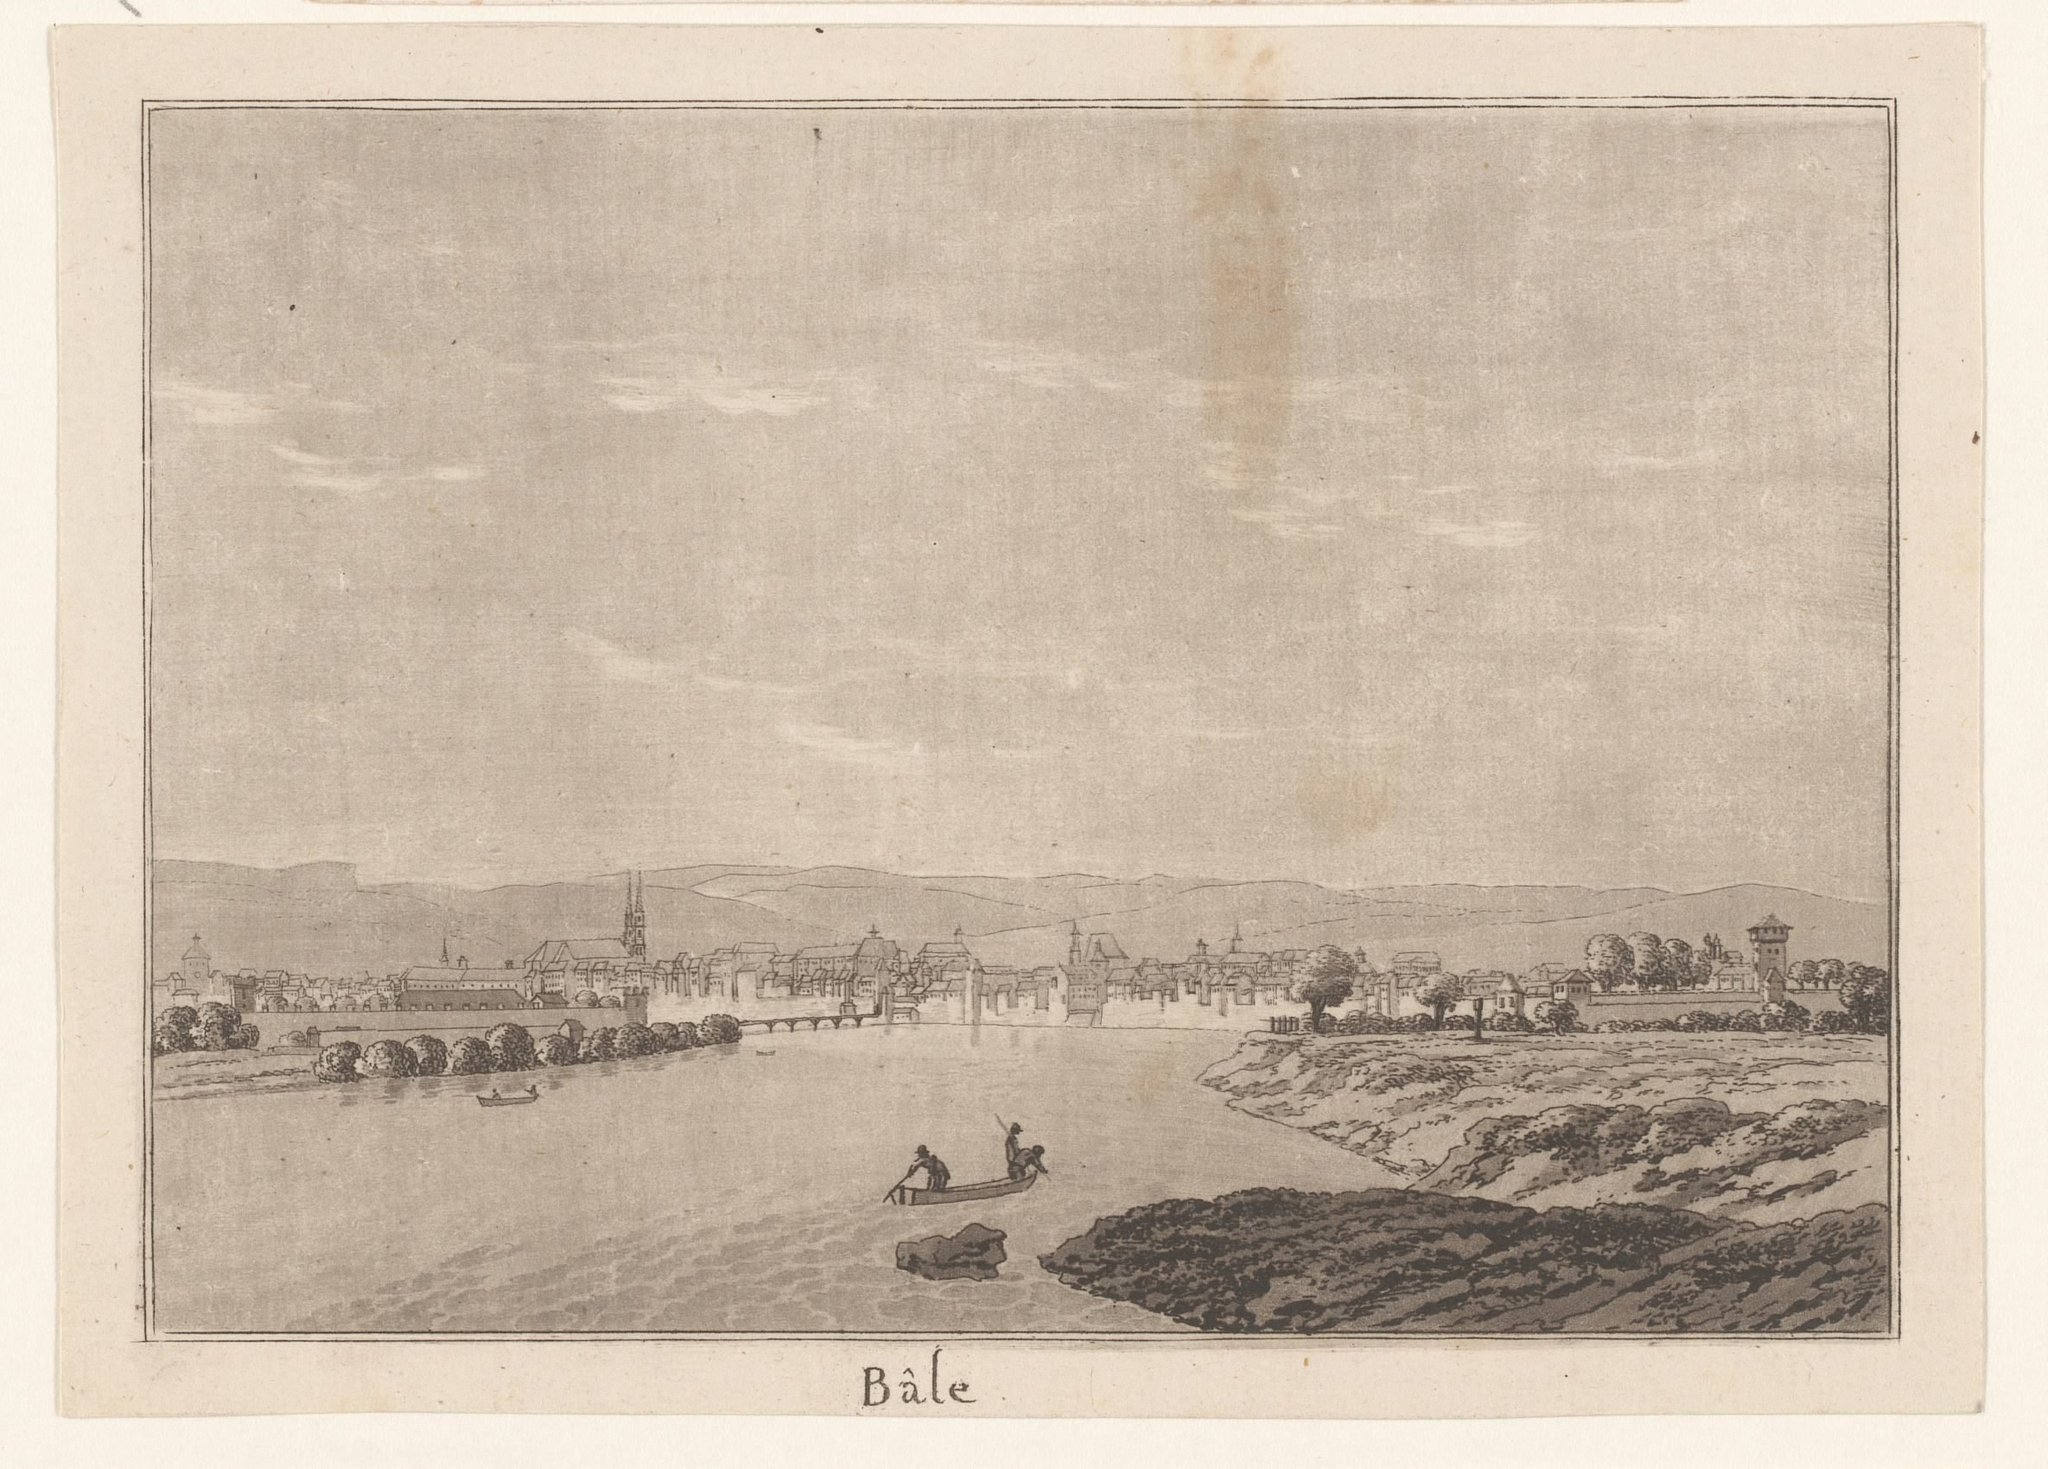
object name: print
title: Bâle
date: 1810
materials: paper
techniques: aquatint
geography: amsterdam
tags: prospect of city, town panorama, silhouette of city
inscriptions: collector's mark: Lugt 2228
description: Prent ook gebruikt in: Promenade Pittoresque dans l'évêché de bâle aux bords de la Birs (...). Amsterdam: T.B. Groebe, 1710.